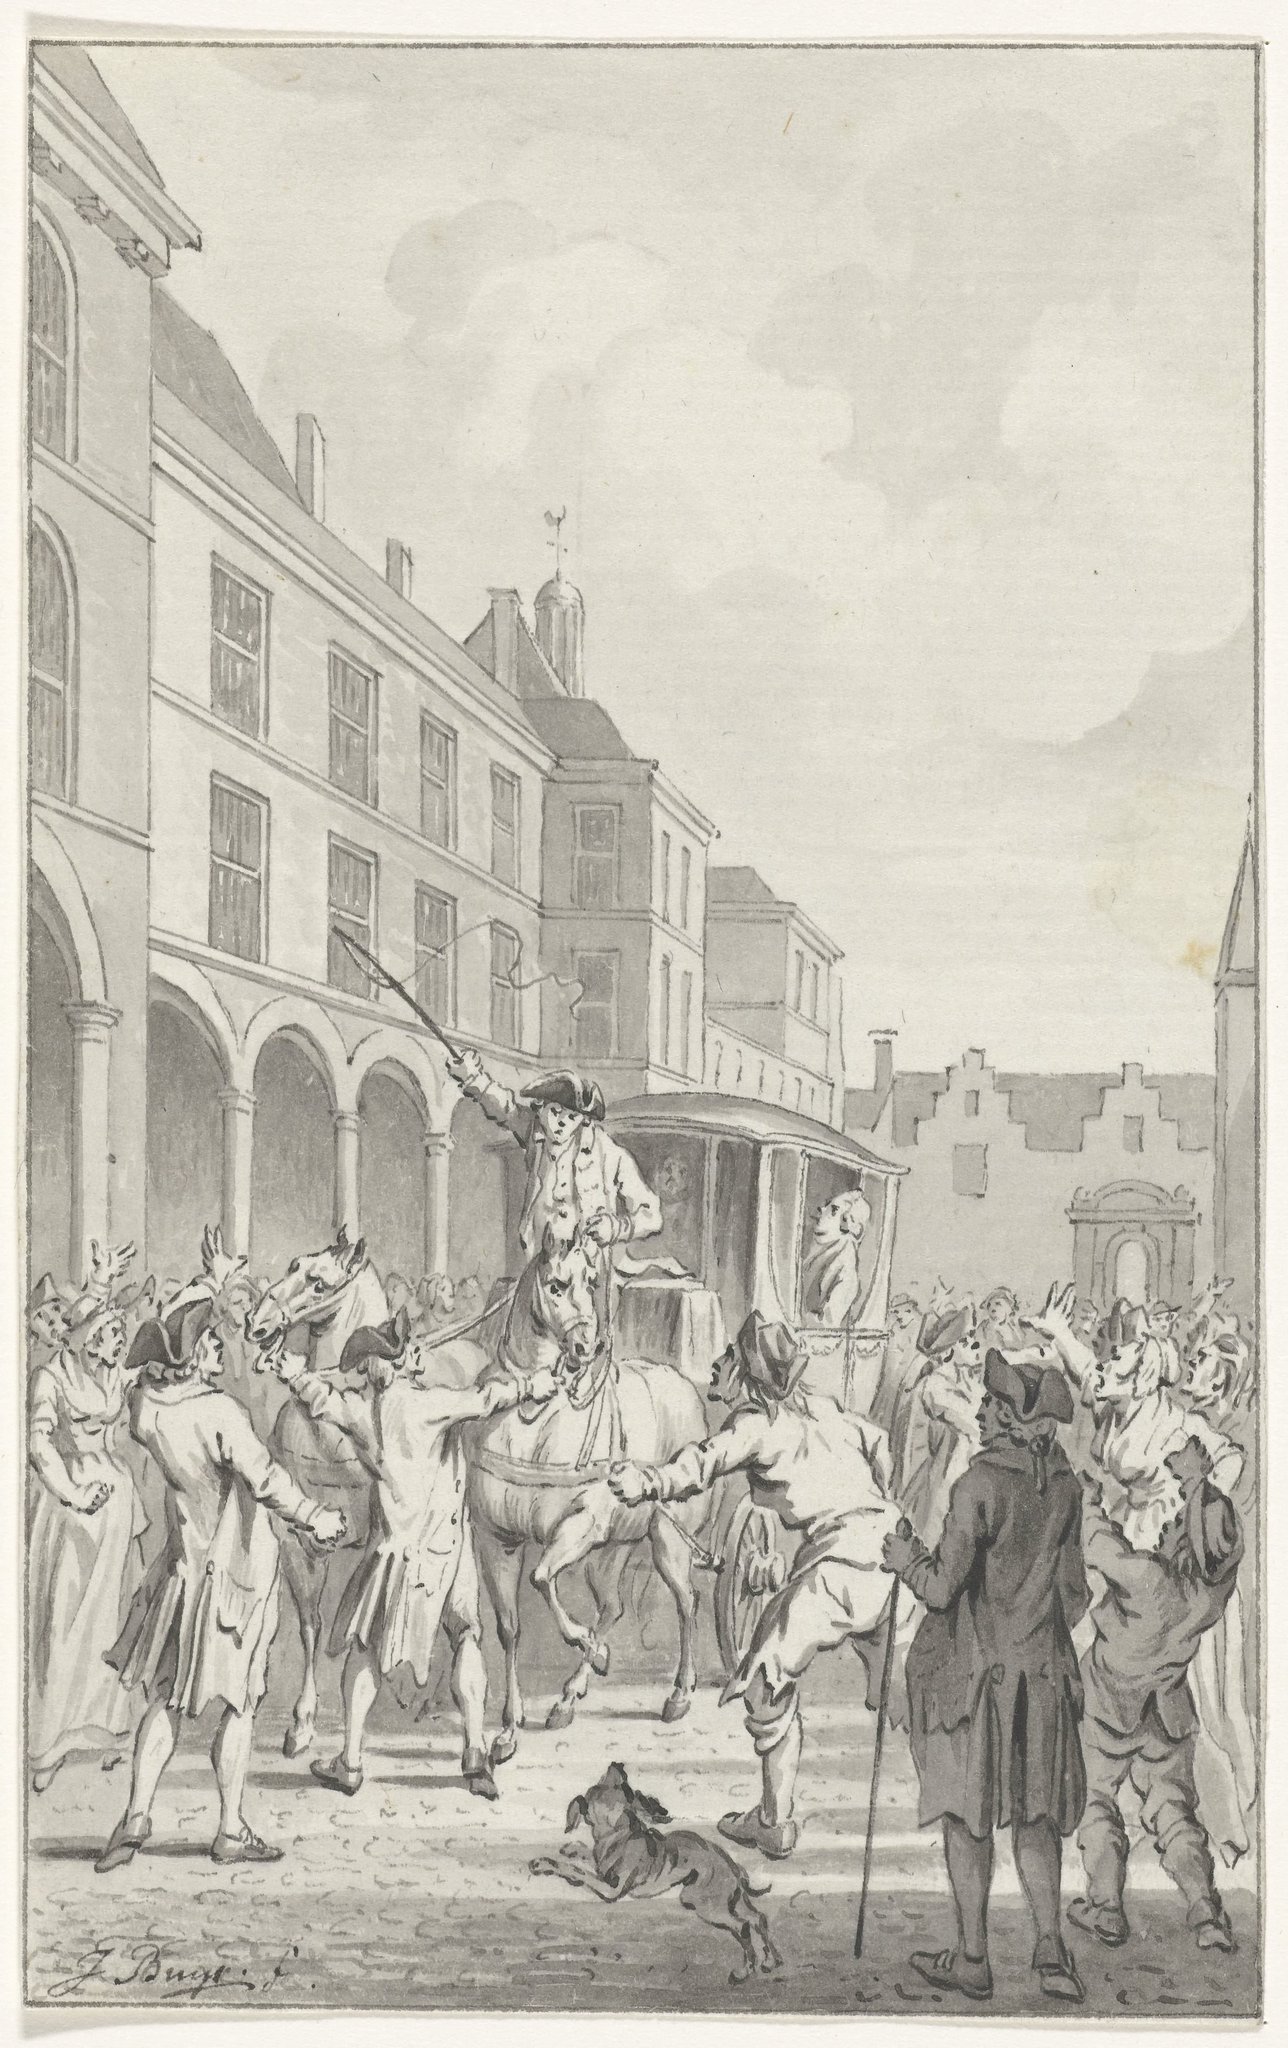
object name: drawing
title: Het tegenhouden van de koets van de heren Gevaarts en De Gijzelaar, gedeputeerden van Dordrecht, op het Binnenhof te Den Haag, 17 maart 1786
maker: jacobus buys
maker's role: draughtsman, print maker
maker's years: 1724-1801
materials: ink, paper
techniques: brush, pen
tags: dordrecht, leiden, historical persons, historical events and situations, the hague